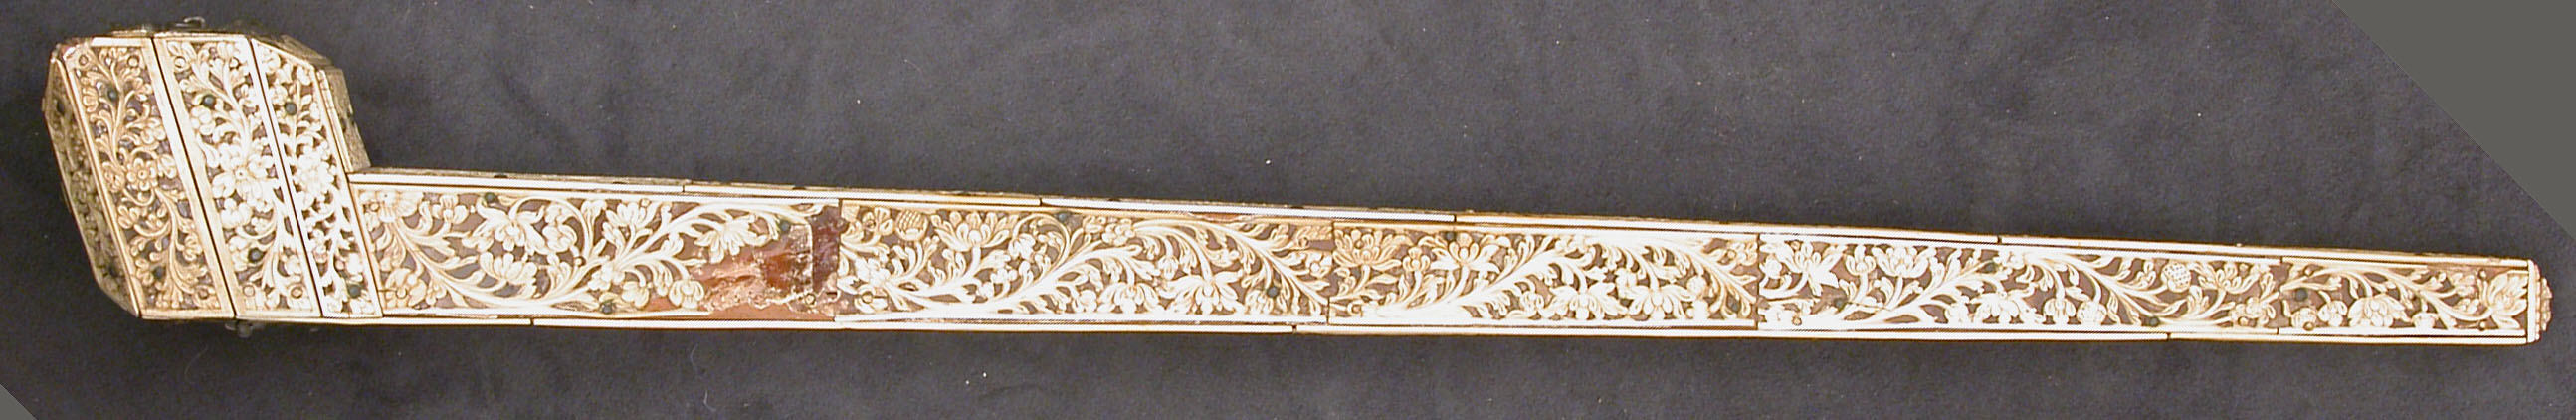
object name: pipe case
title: Case for Two Pipes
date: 1601-1700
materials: brass, ivory, wood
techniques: carving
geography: india